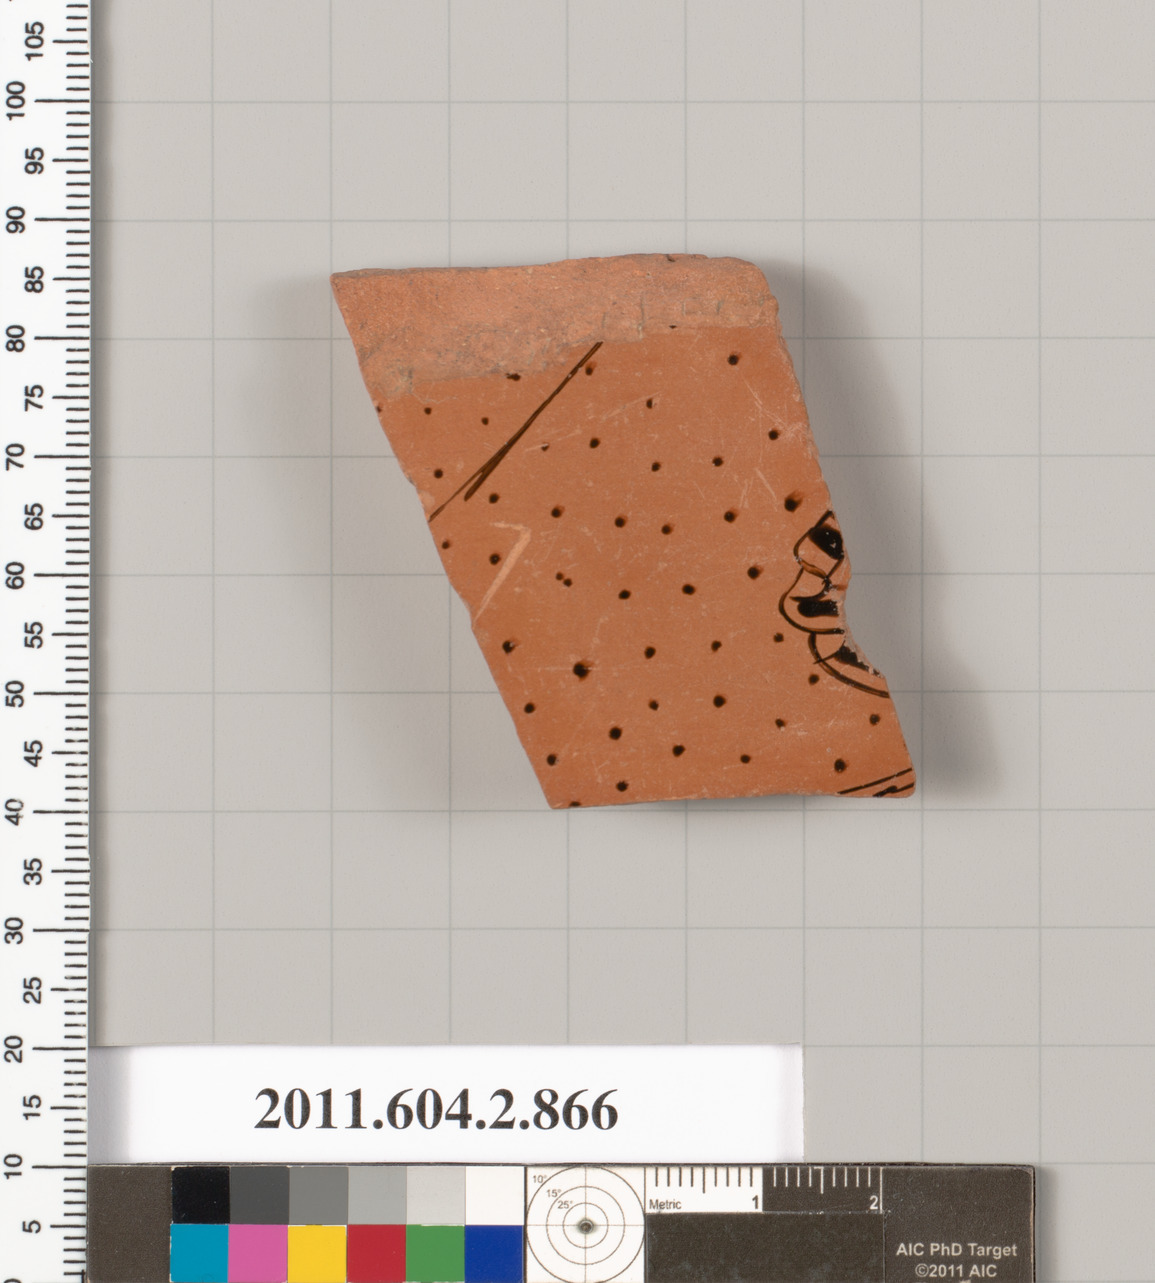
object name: bell krater fragment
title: Terracotta fragment of a bell-krater (bowl for mixing wine and water)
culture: greek, attic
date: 460-450 BCE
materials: terracotta